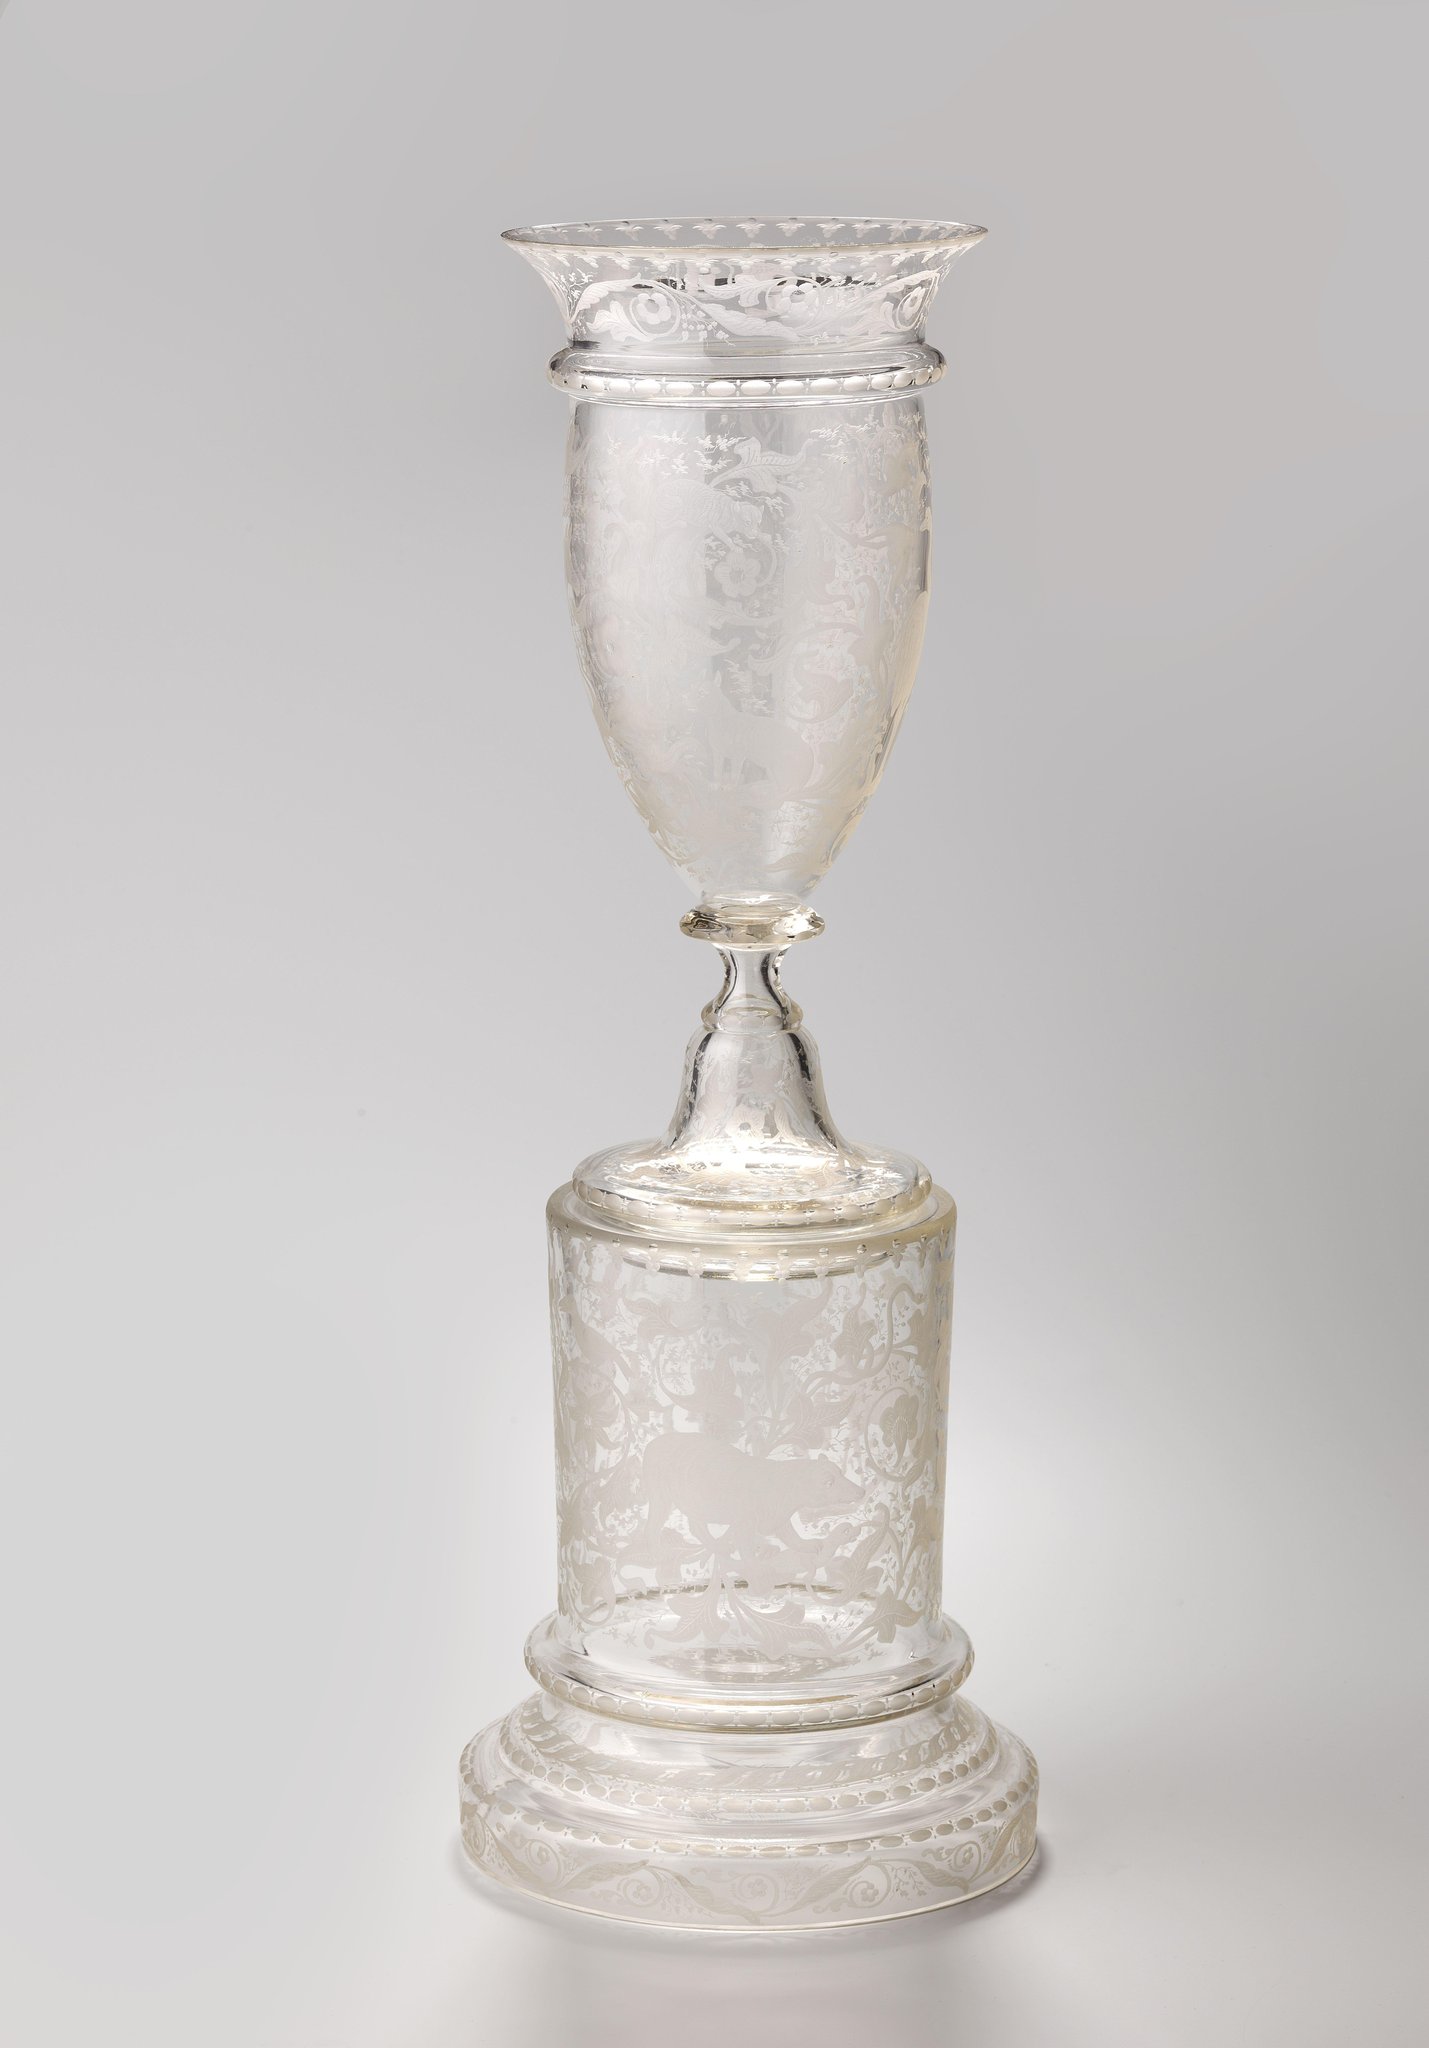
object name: vase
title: Sokkel van vaas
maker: Anonymous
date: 1850-1900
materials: glass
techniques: glassblowing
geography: bohemia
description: Holle sokkel, met een geprofileerde basis en een cylindrisch lichaam. De sokkel is versierd met een menagerie tussen blad- en bloemranken.